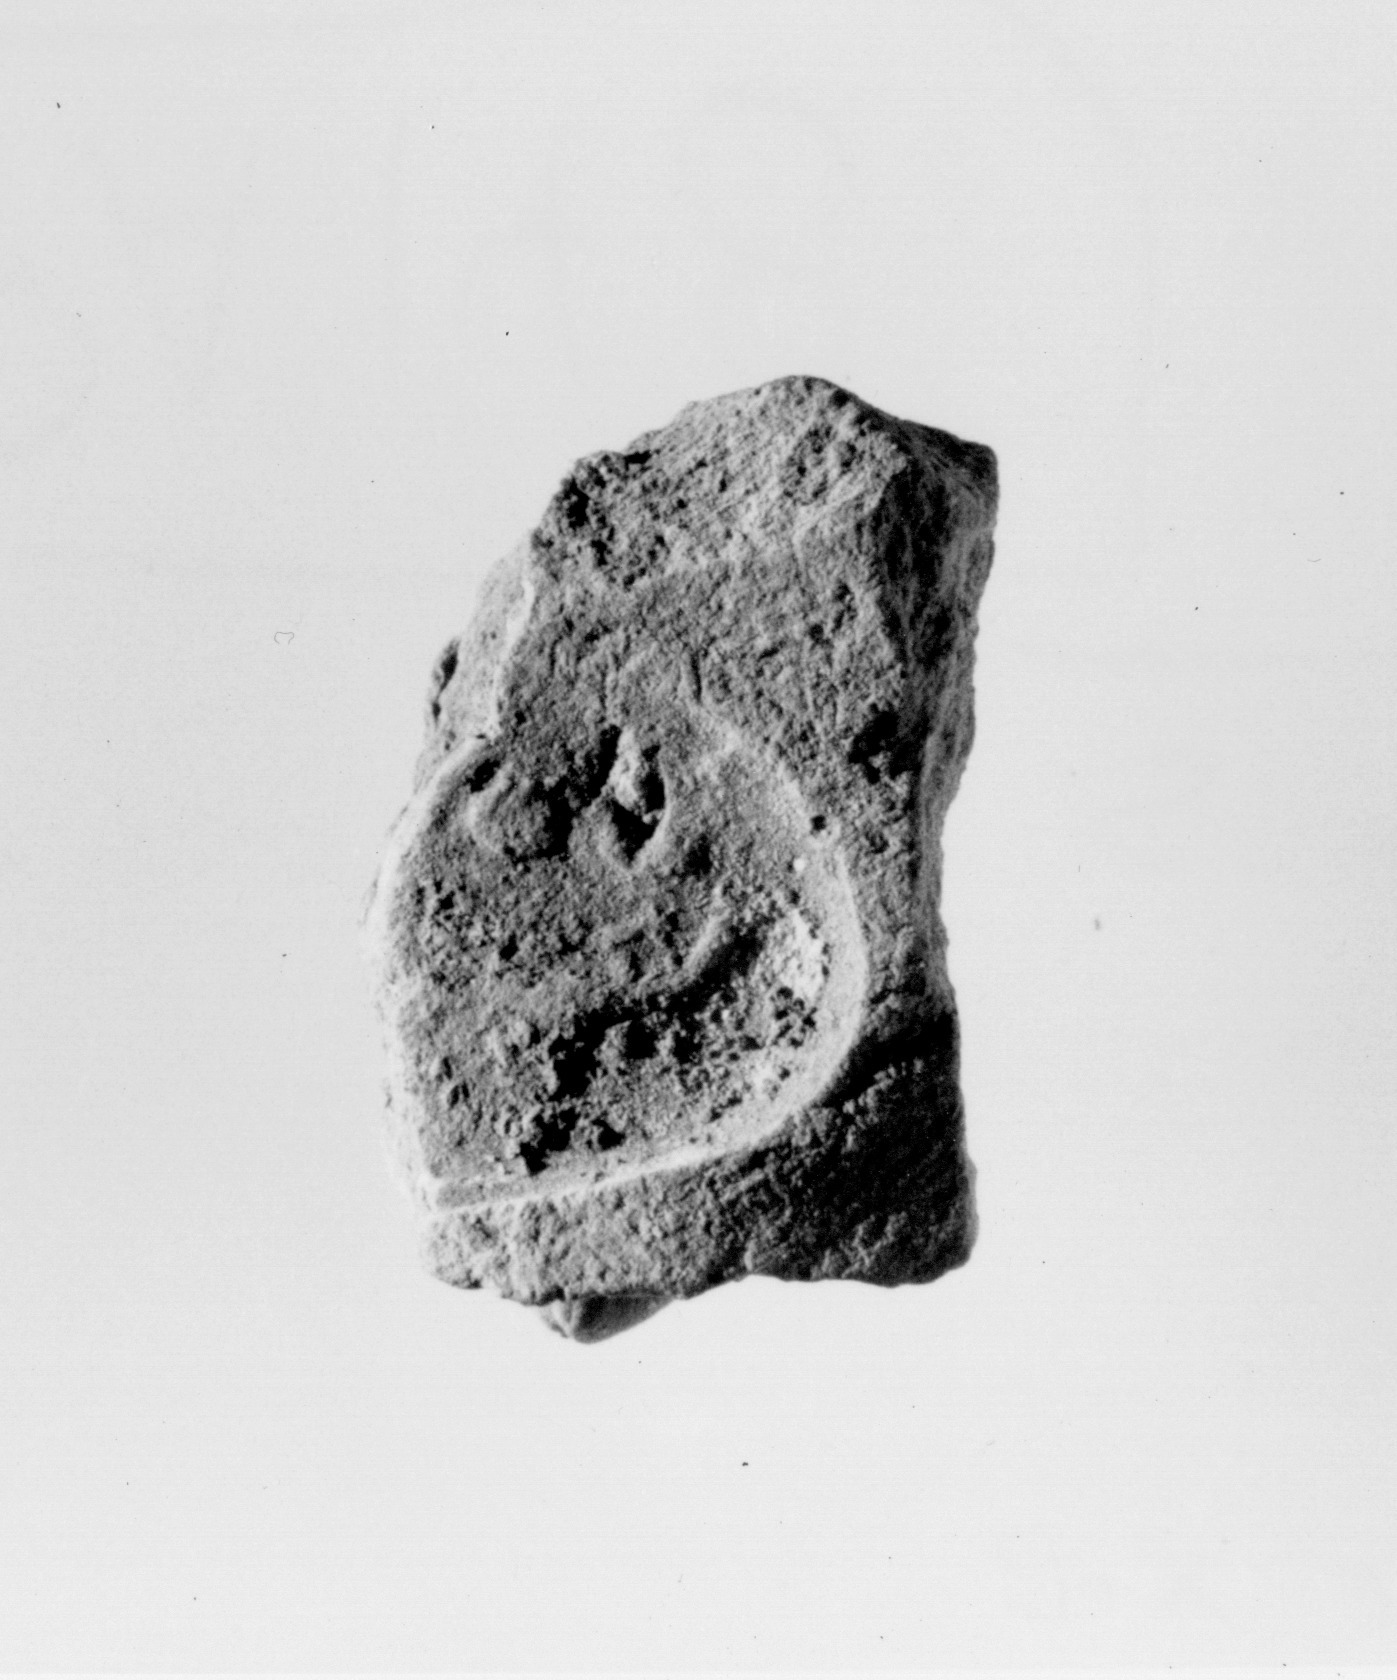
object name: sealing, nebmaatre, amenhotep iii,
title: Document Sealing With the Throne Name of Amenhotep III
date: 1390-1352 BCE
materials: mud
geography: egypt